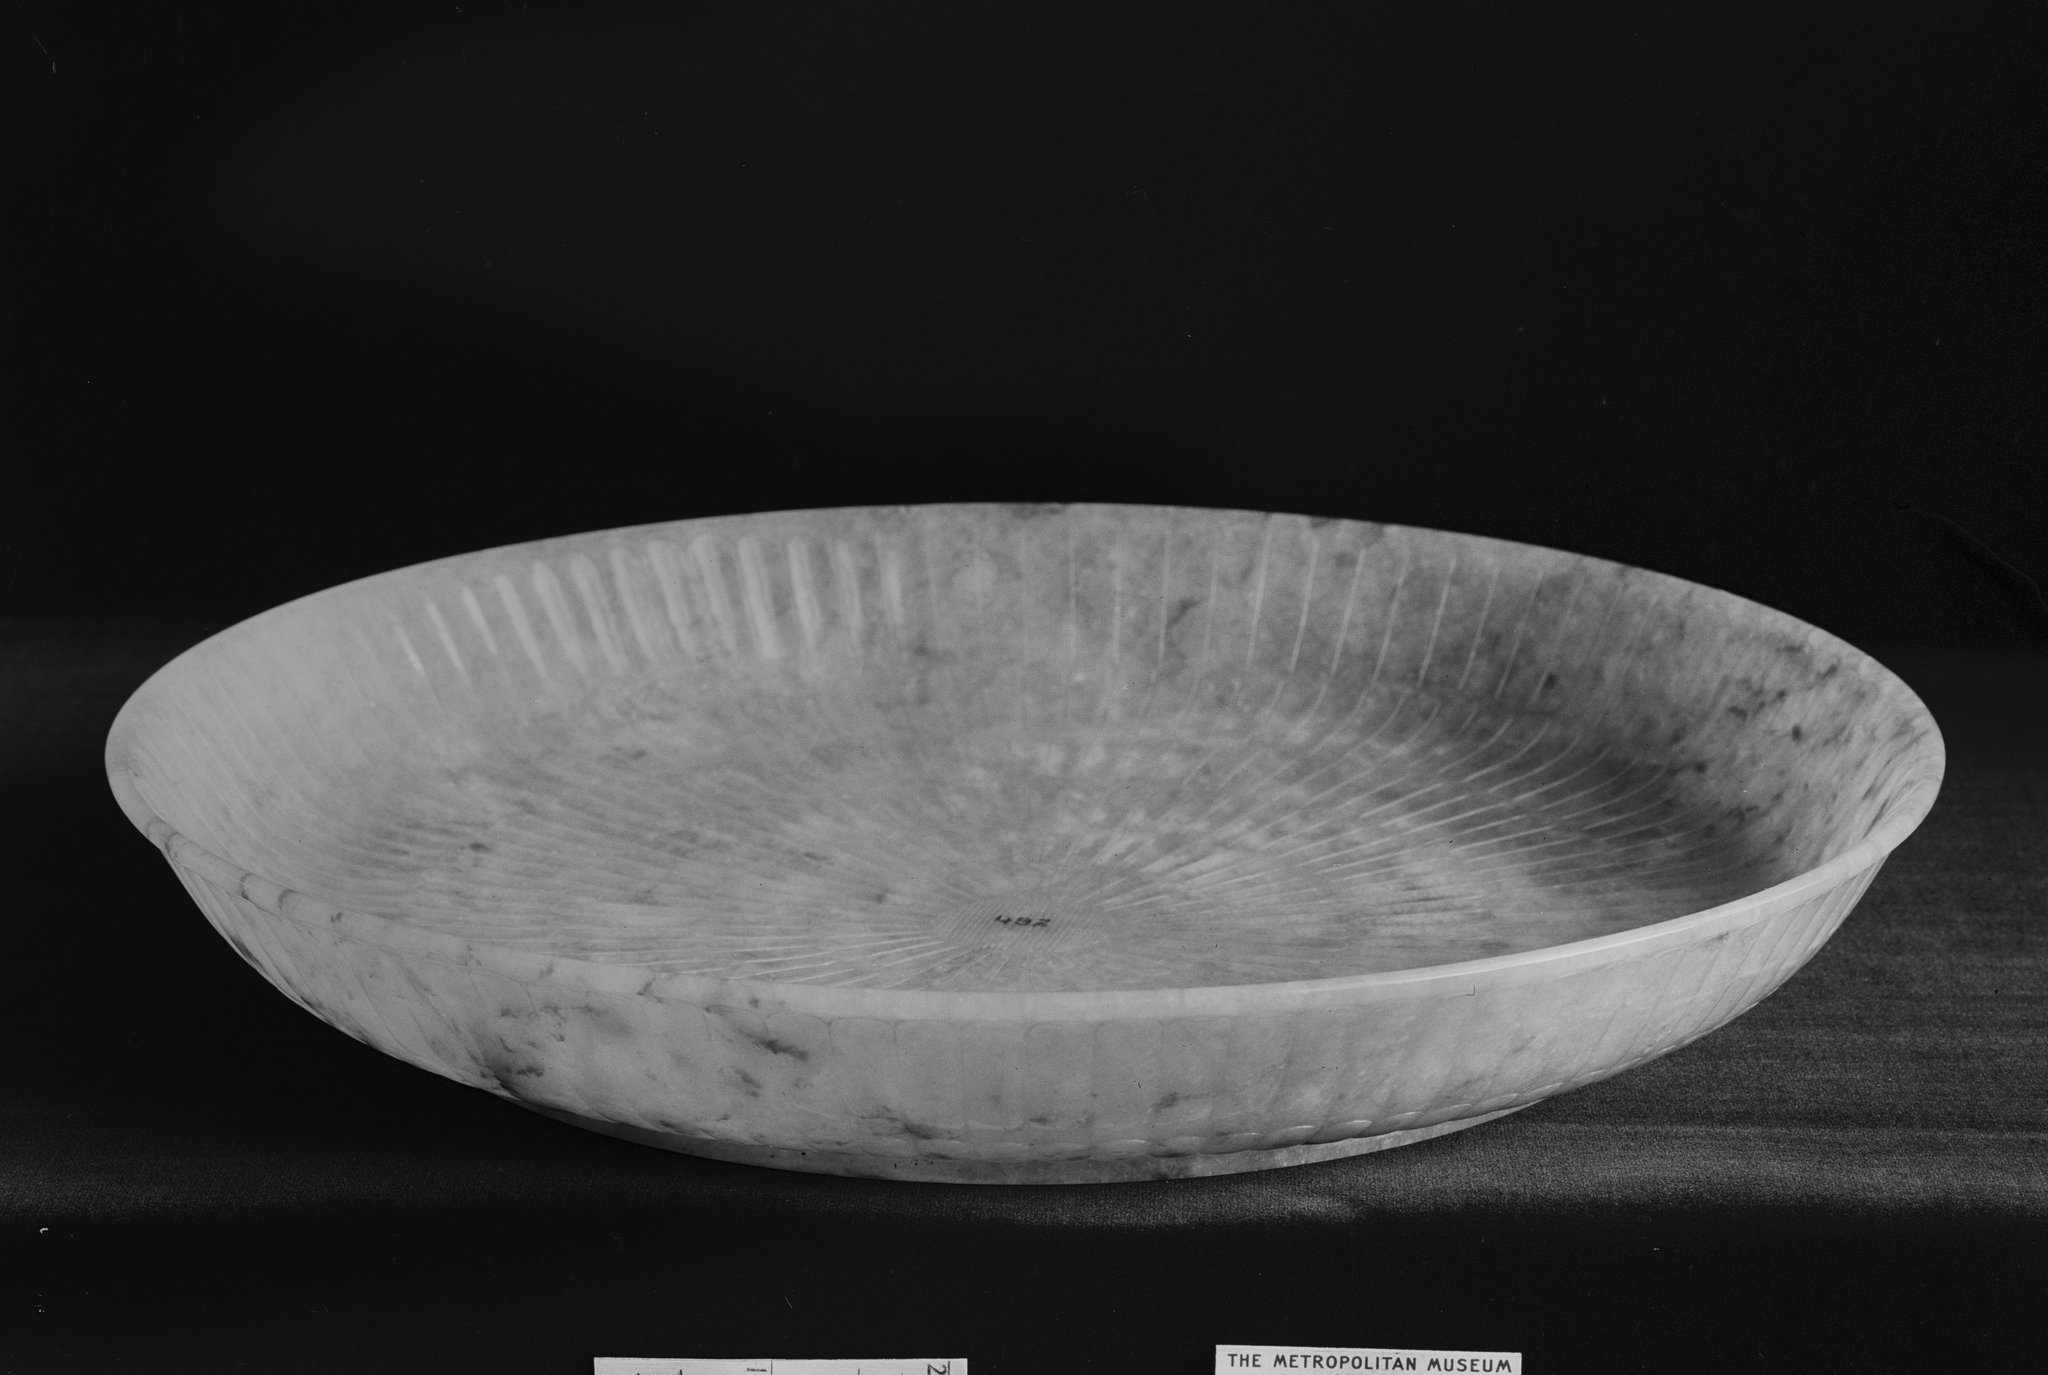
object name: dish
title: Dish in the shape of a chrysanthemum flower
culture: chinese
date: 1701-1900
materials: jade